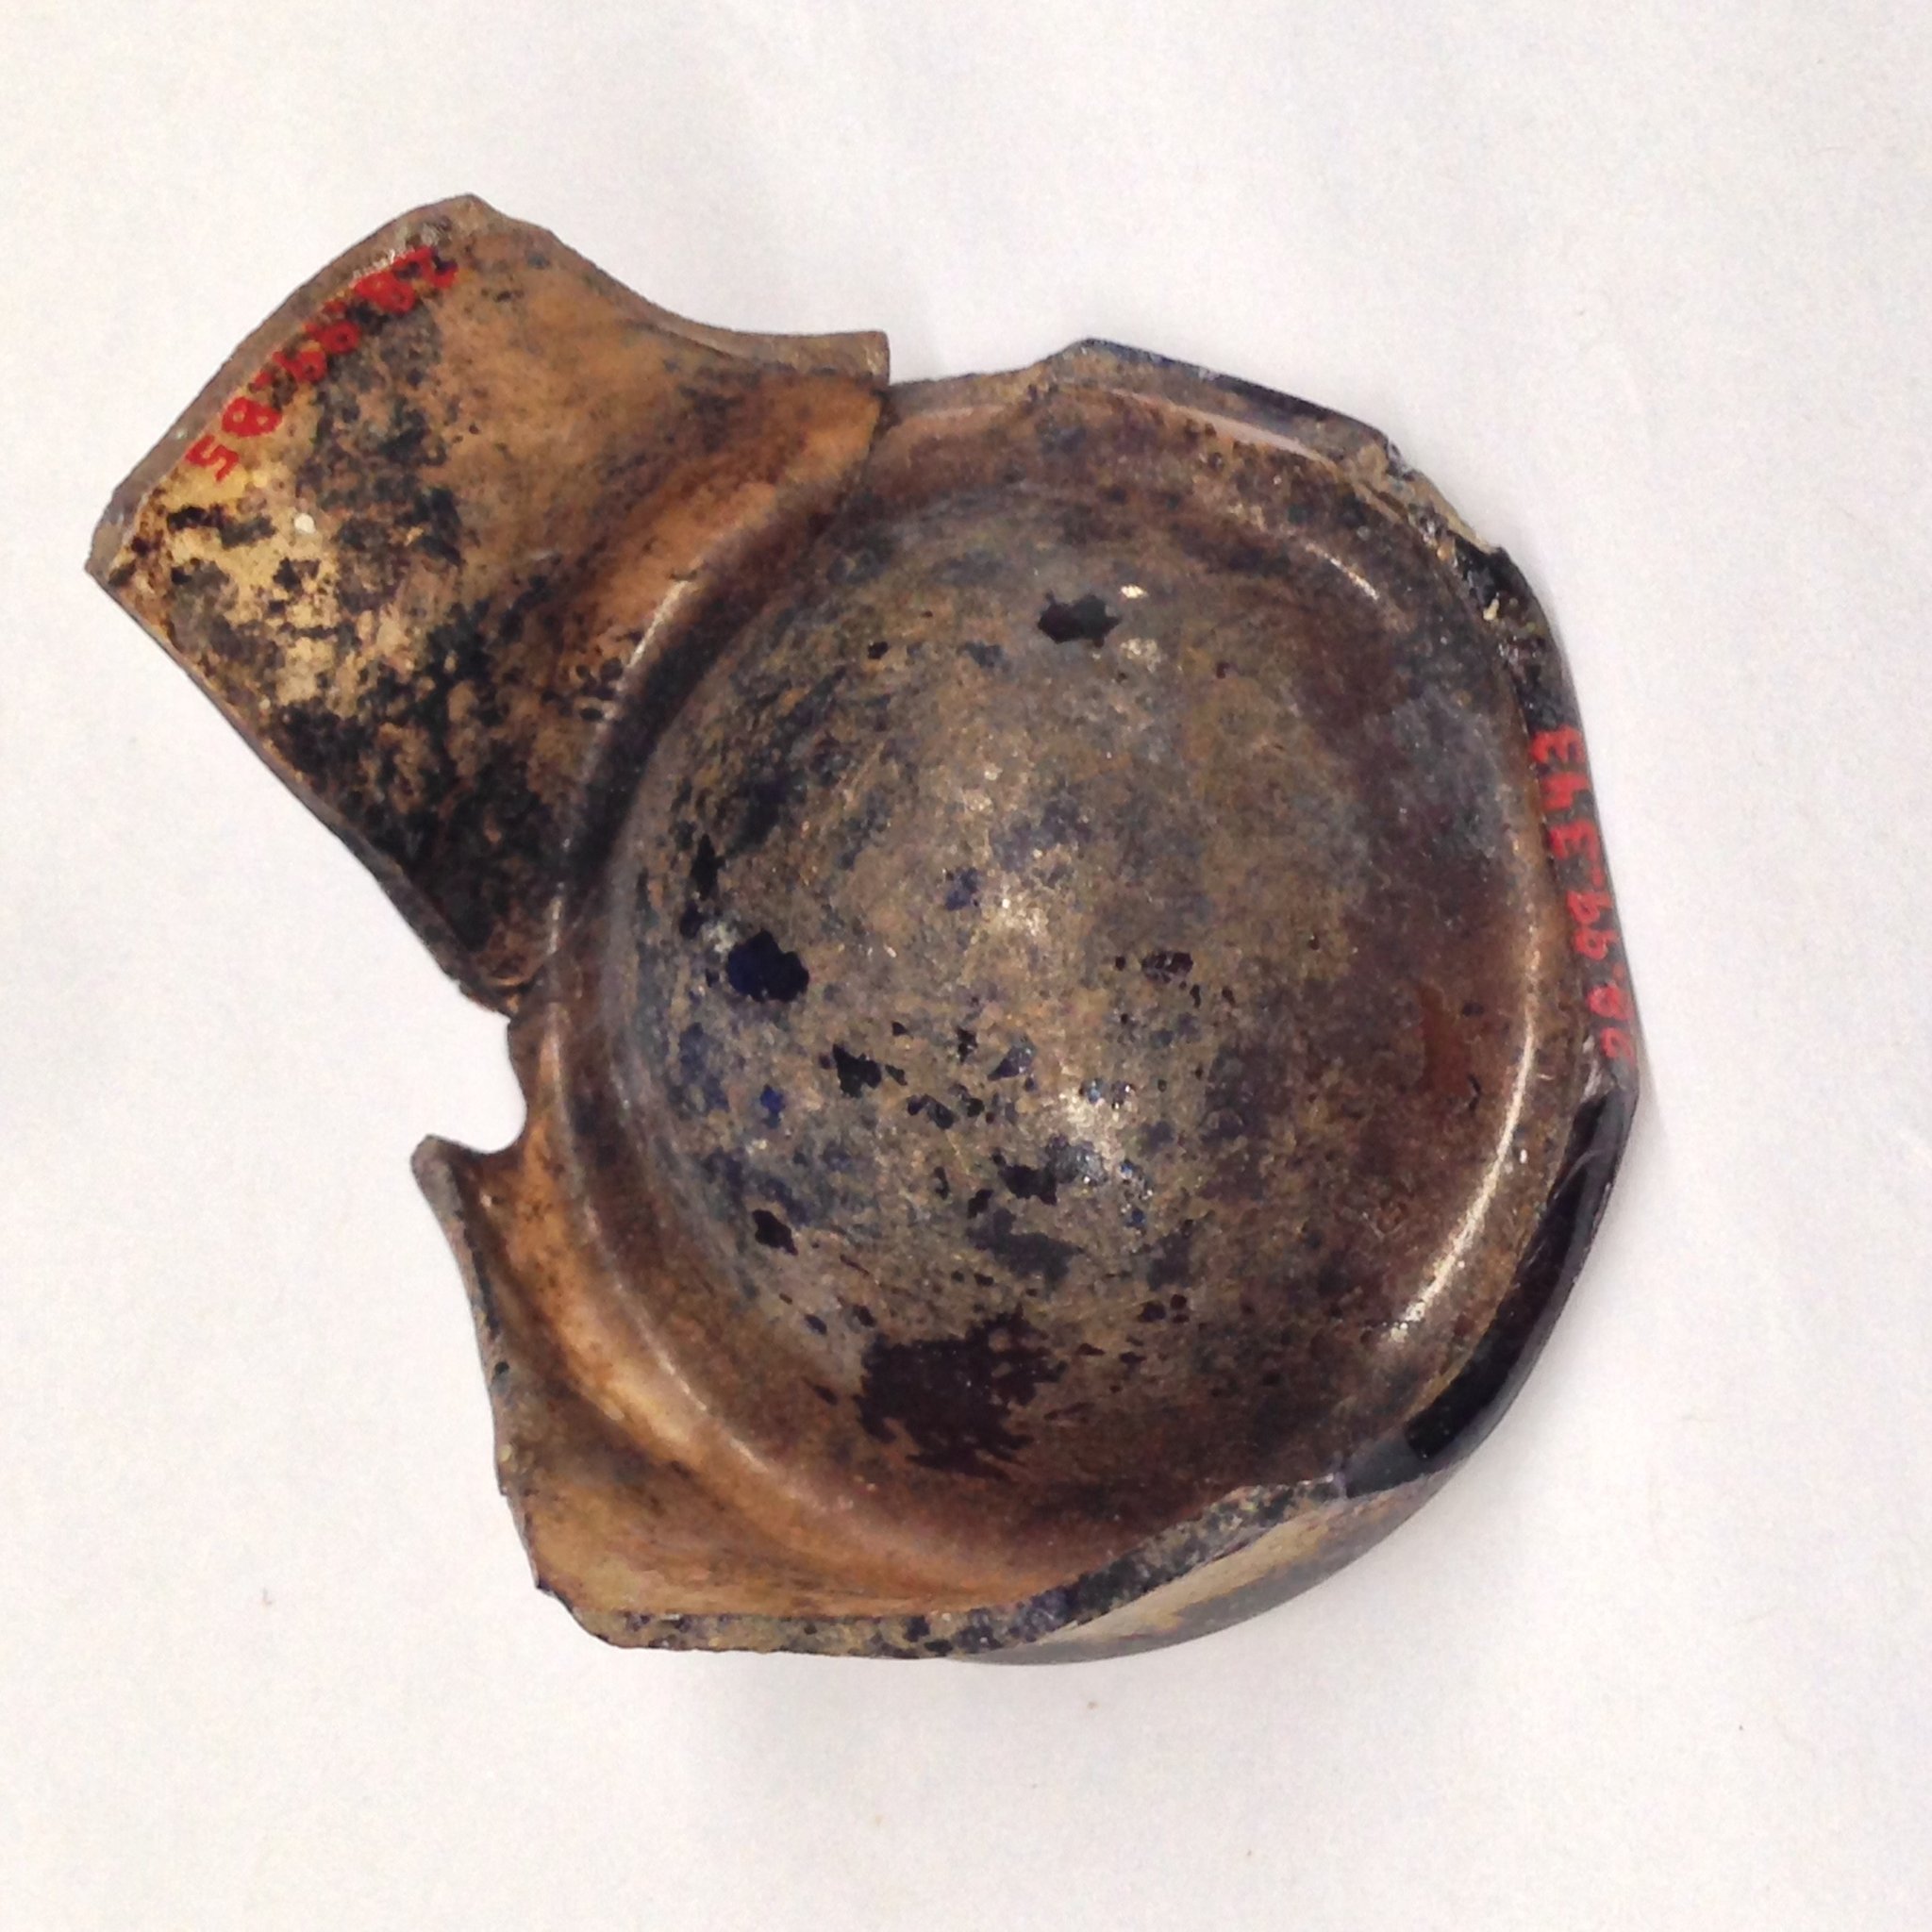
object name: fragment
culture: european or middle eastern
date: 1150-1250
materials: ceramic, glass